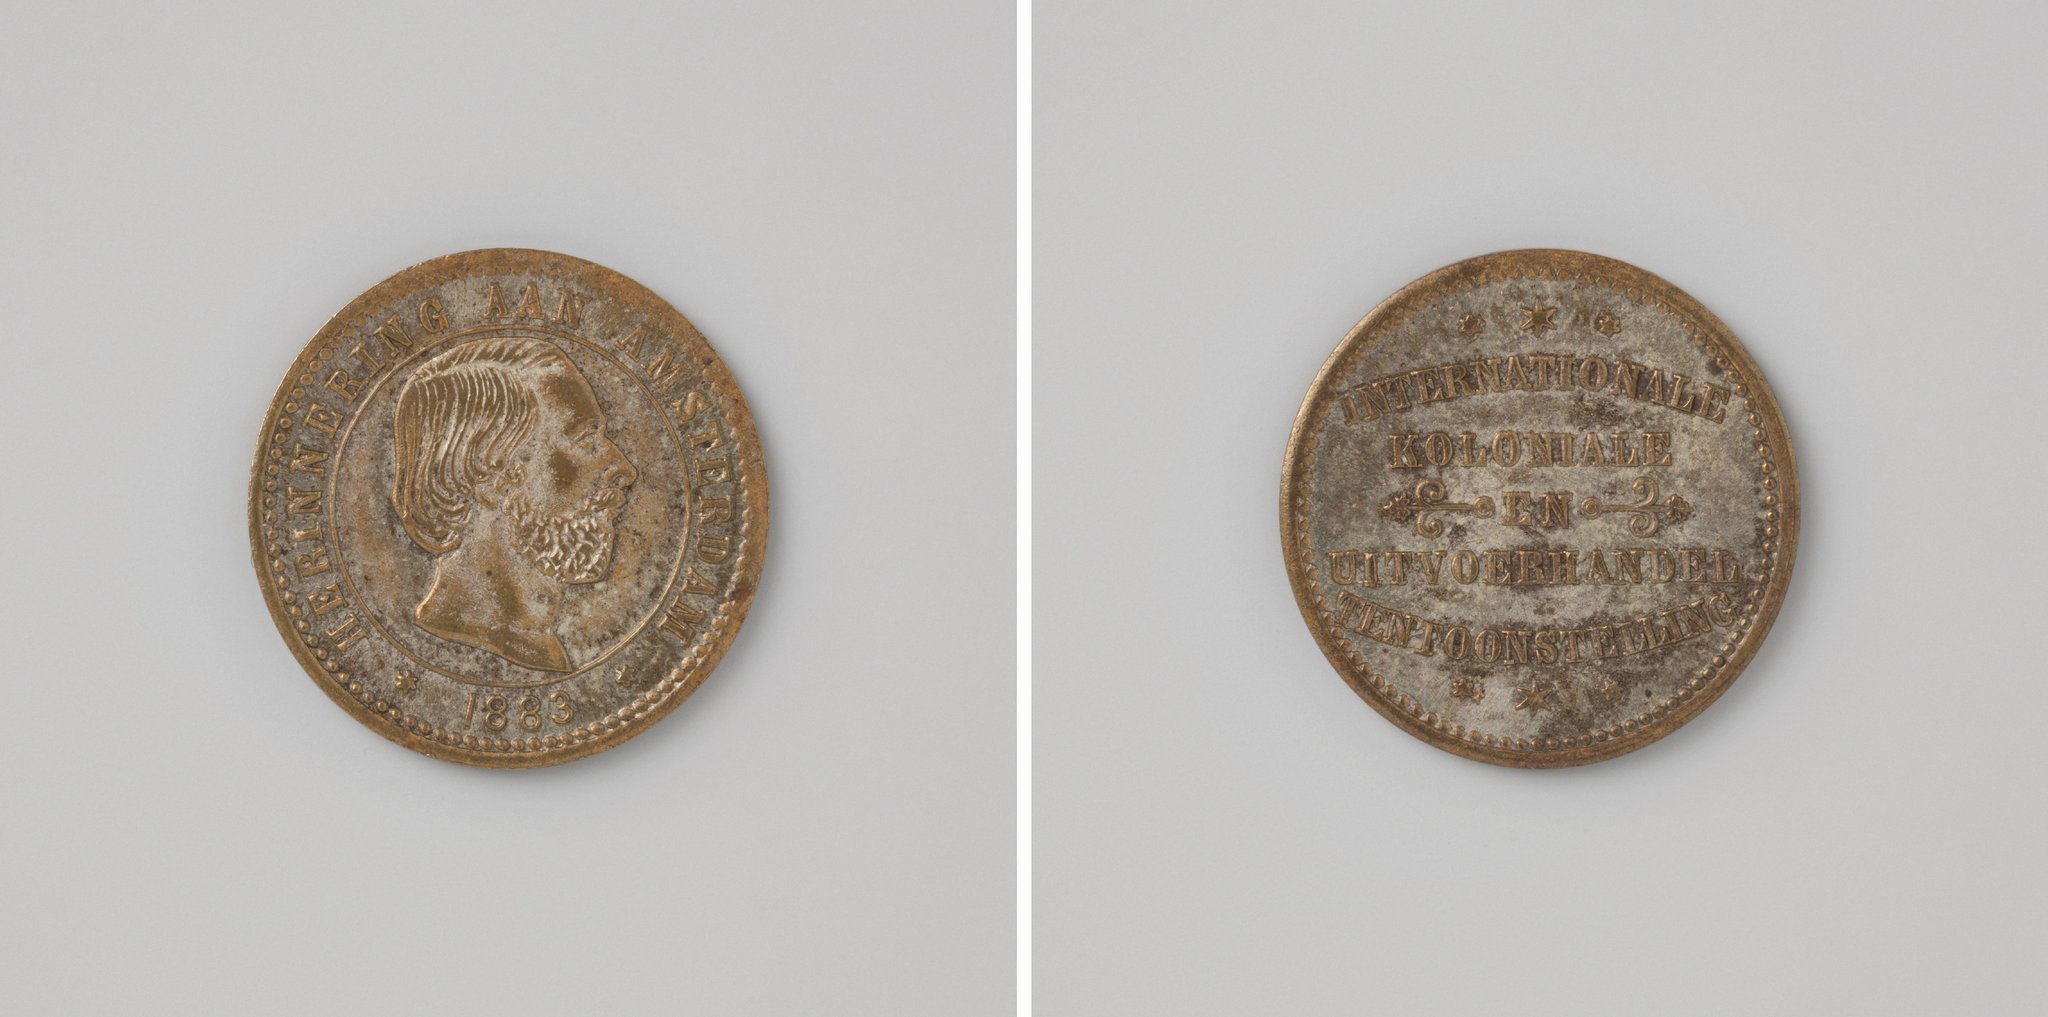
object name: history medal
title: Internationale Koloniale en Uitvoerhandel-Tentoonstelling te Amsterdam 1883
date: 1883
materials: brass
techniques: striking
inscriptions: circumscription: ‘HERINNERING AAN AMSTERDAM / 1883’, inscription: ‘INTERNATIONALE / KOLONIALE / EN / UITVOERHANDEL / TENTOONSTELLING’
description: Verzilverd messing penninkje, op de voorzijde het portret van Willem III naar rechts, met omschrift, op de keerzijde vijf regels tekst.